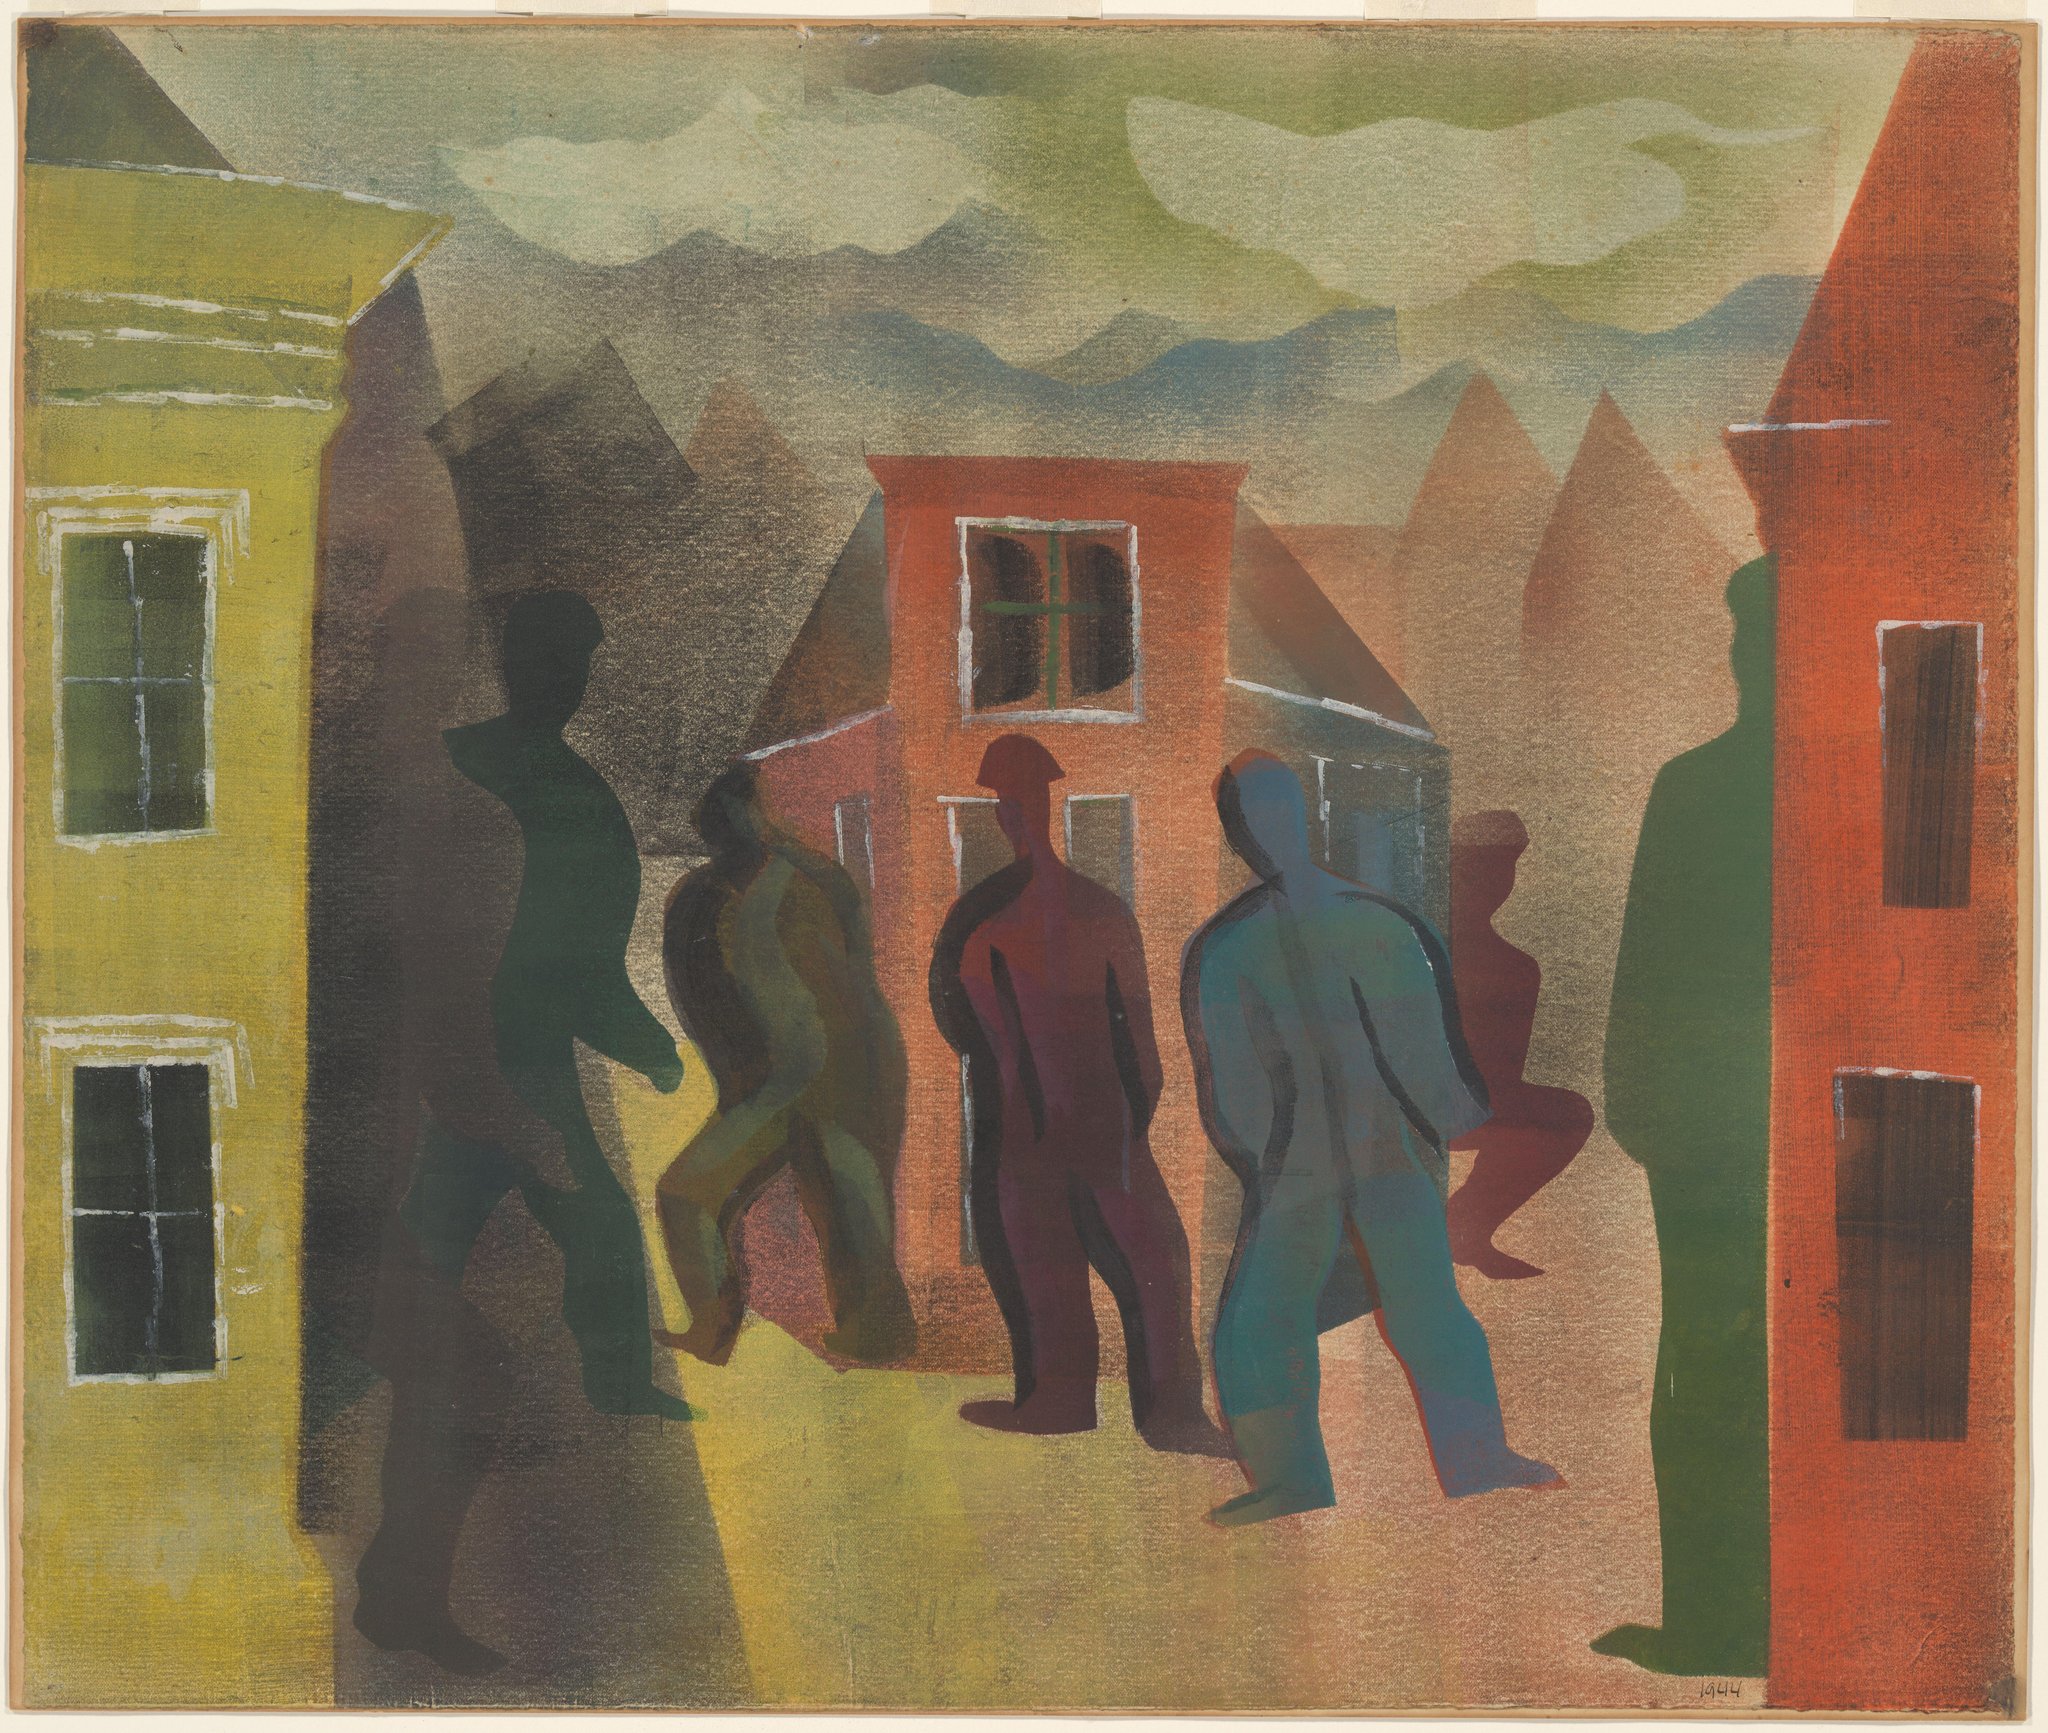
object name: print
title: Street scene with figures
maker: hendrik nicolaas werkman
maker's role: print maker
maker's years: 1882-1945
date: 1944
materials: paper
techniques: printing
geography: groningen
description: Groningen printer, artist and resistance fighter Werkman was shot dead by the Nazis shortly before the end of the Second World War. This print is one of the few works in which he depicted the war which would cost him his life. A group of resistance members, depicted here as shadows, has gathered together on the street shortly before the curfew begins in order to have a secret conversation in the twilight.